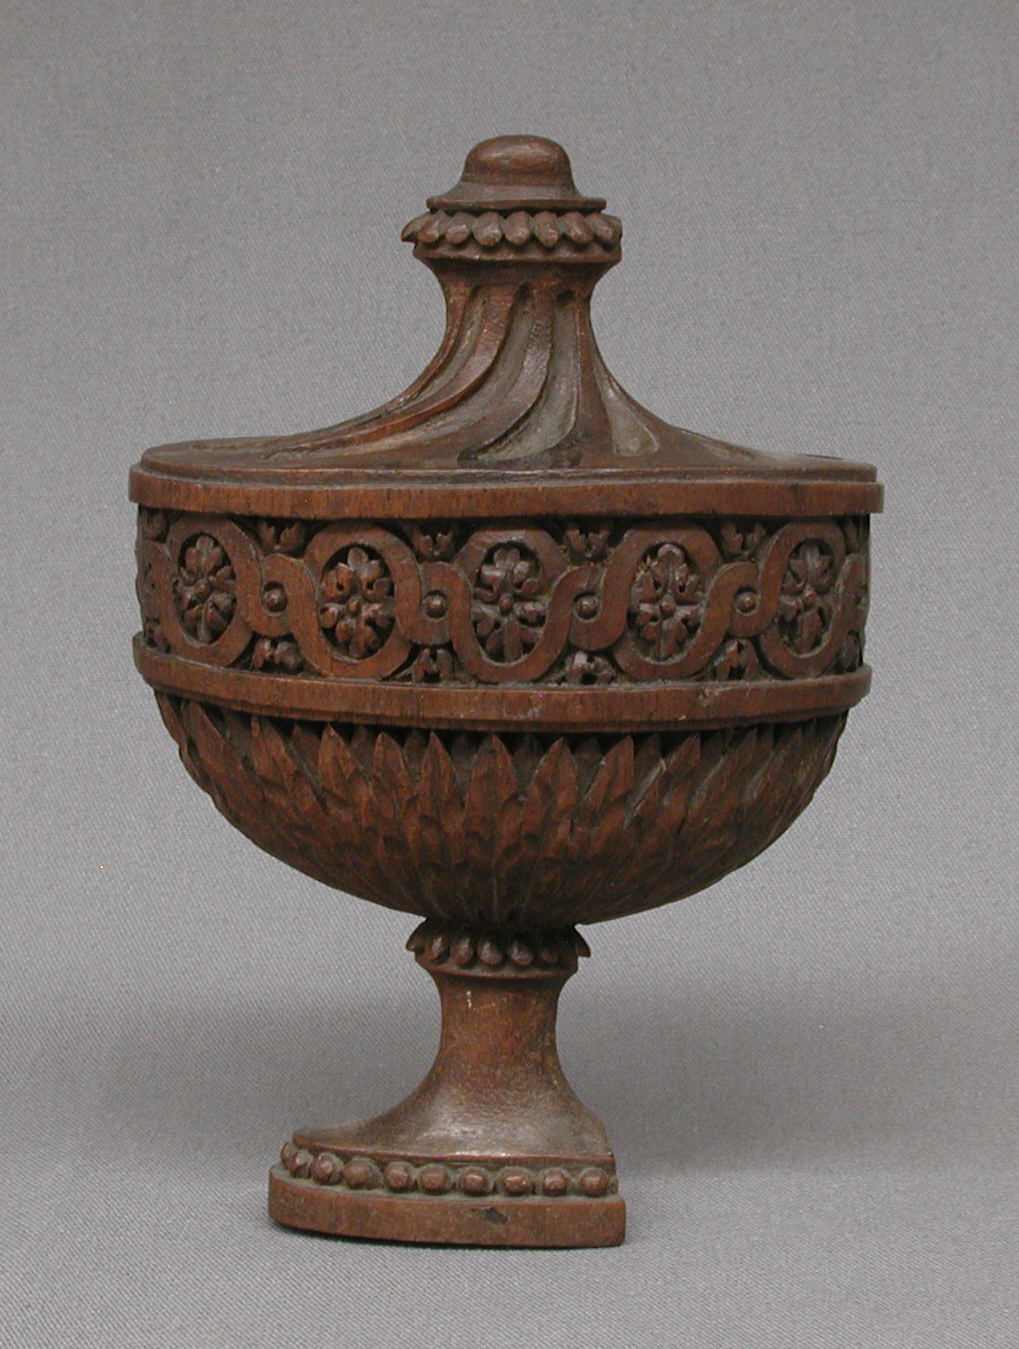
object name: vase detail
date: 1701-1800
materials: wood